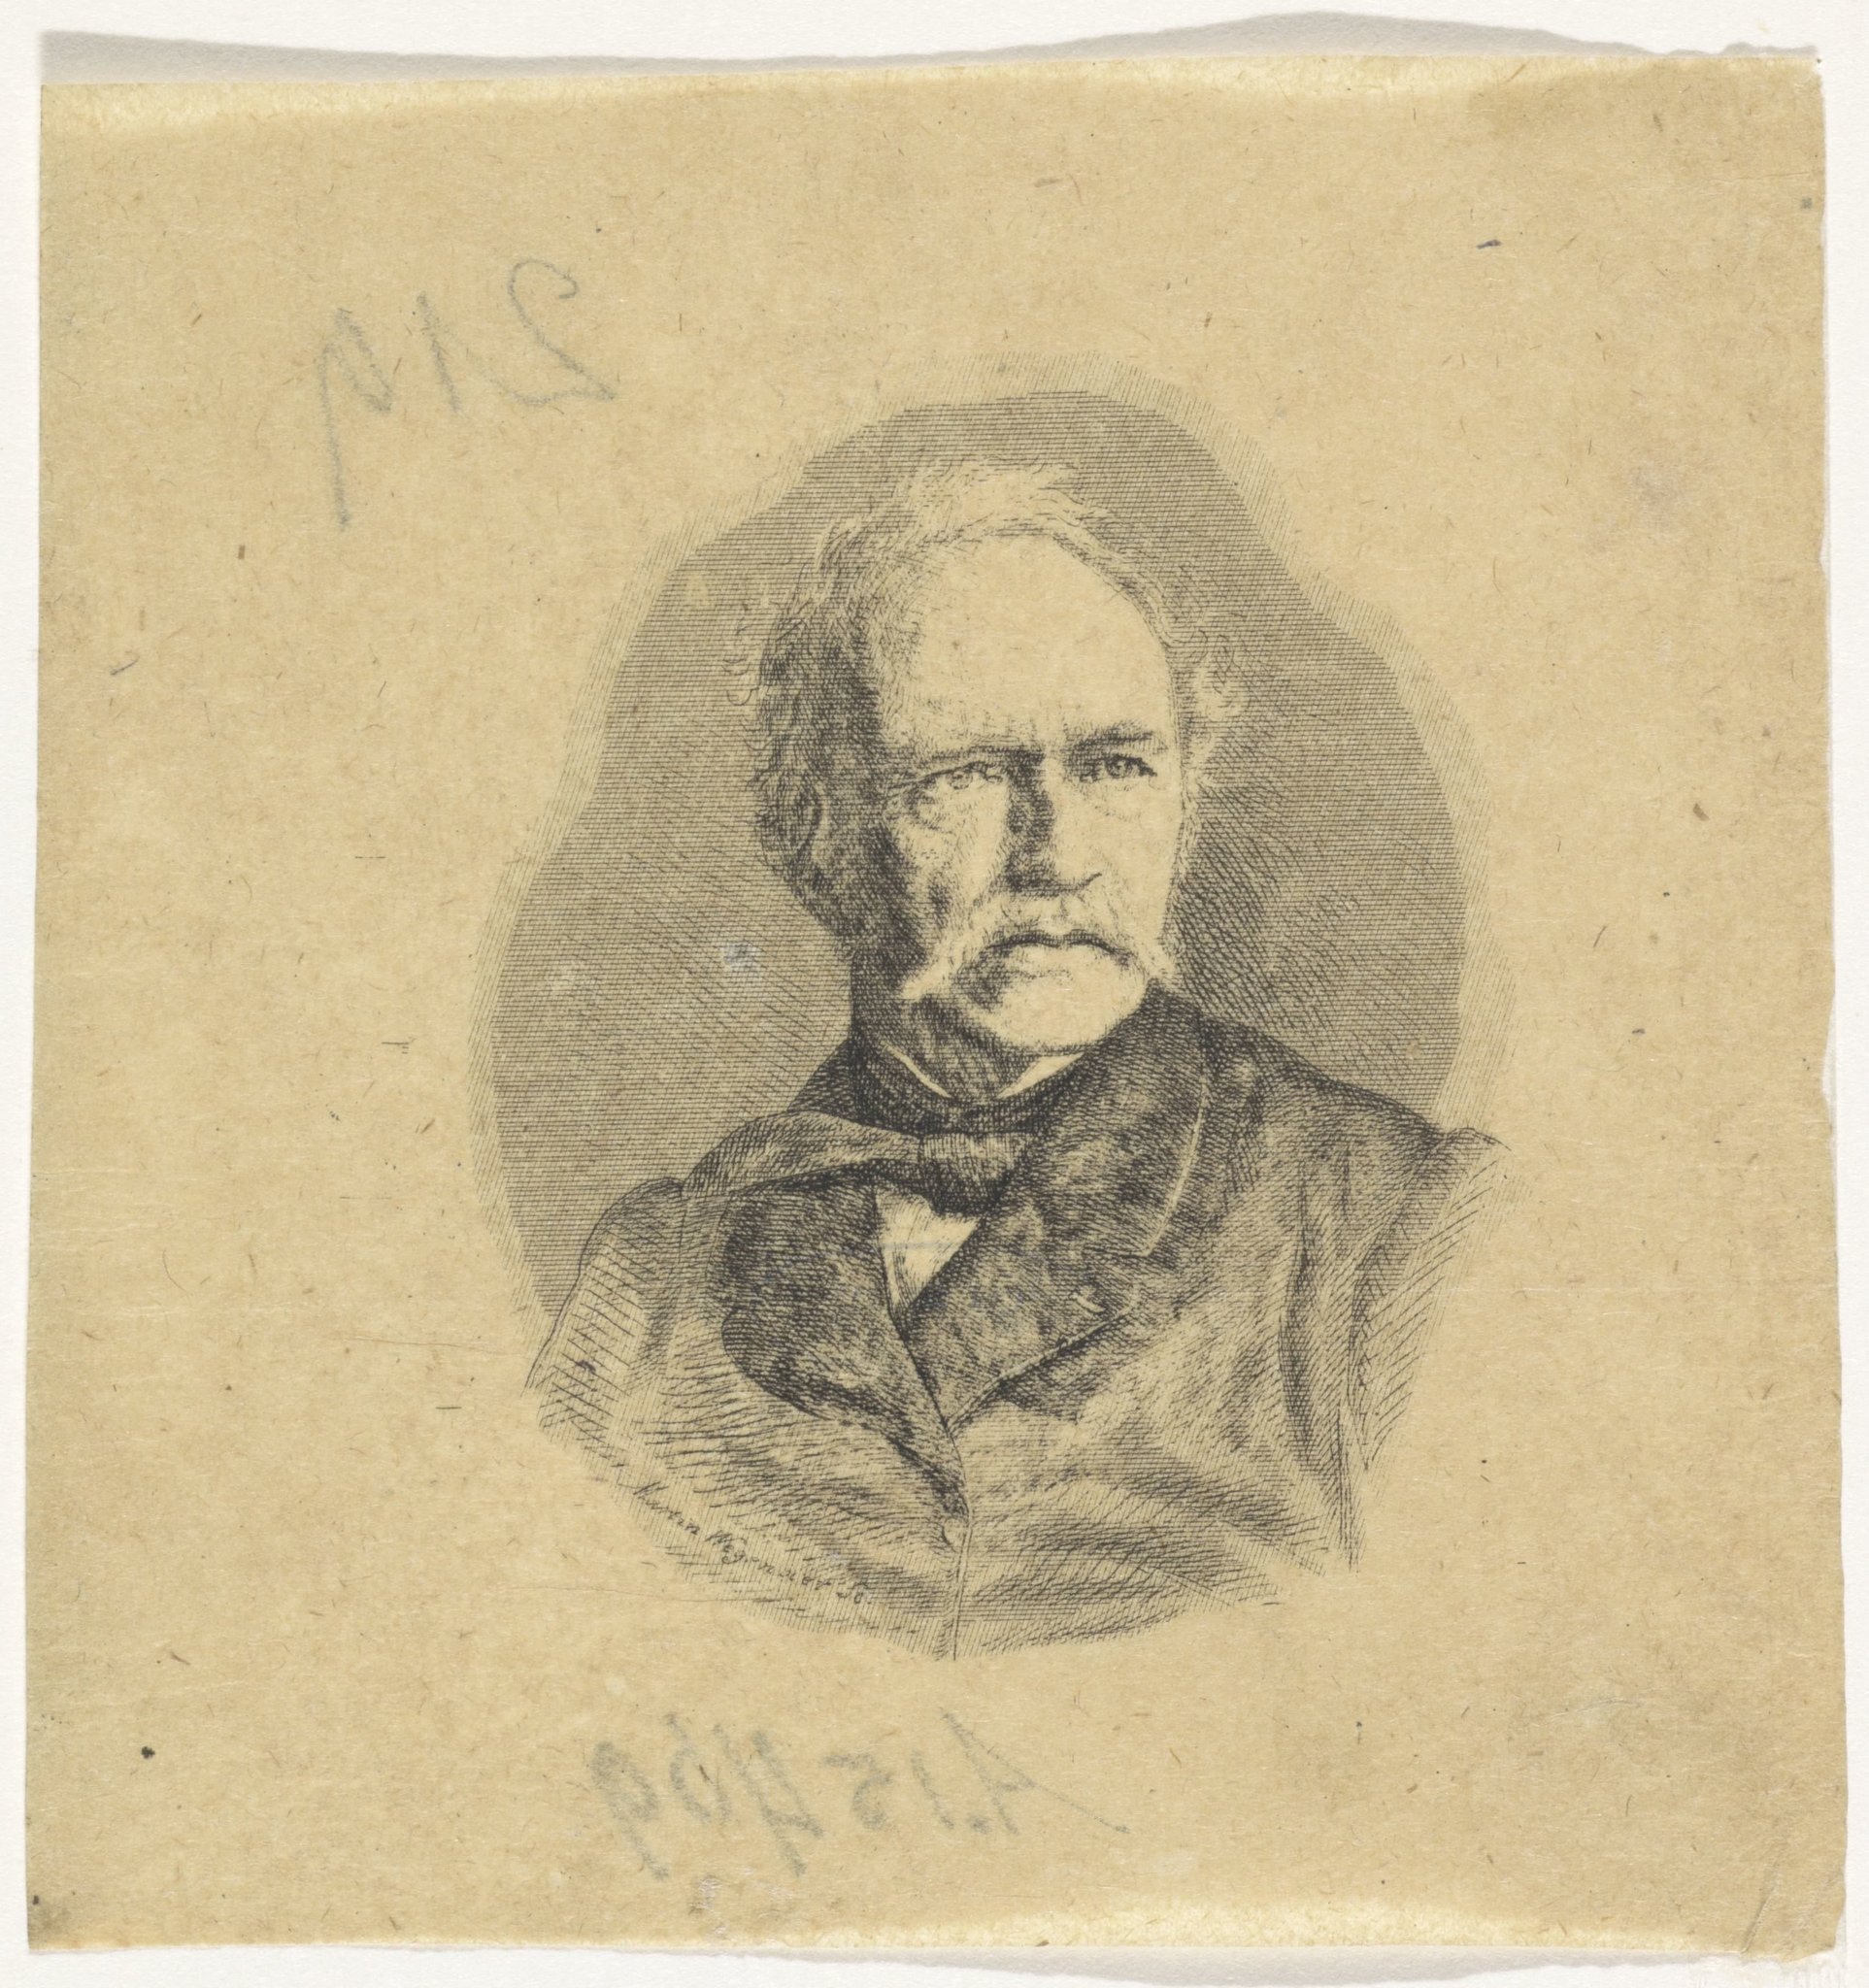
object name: print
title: Portret van de beeldhouwer Johannes Antonius van der Ven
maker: martinus johannes cornelis weegenaar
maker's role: print maker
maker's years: 1834-1909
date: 1849-1890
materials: paper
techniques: etching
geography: rosmalen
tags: draughtsman, sculptor, jan antonie van der ven, portrait, self-portrait of sculptor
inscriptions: collector's mark: Lugt 2228